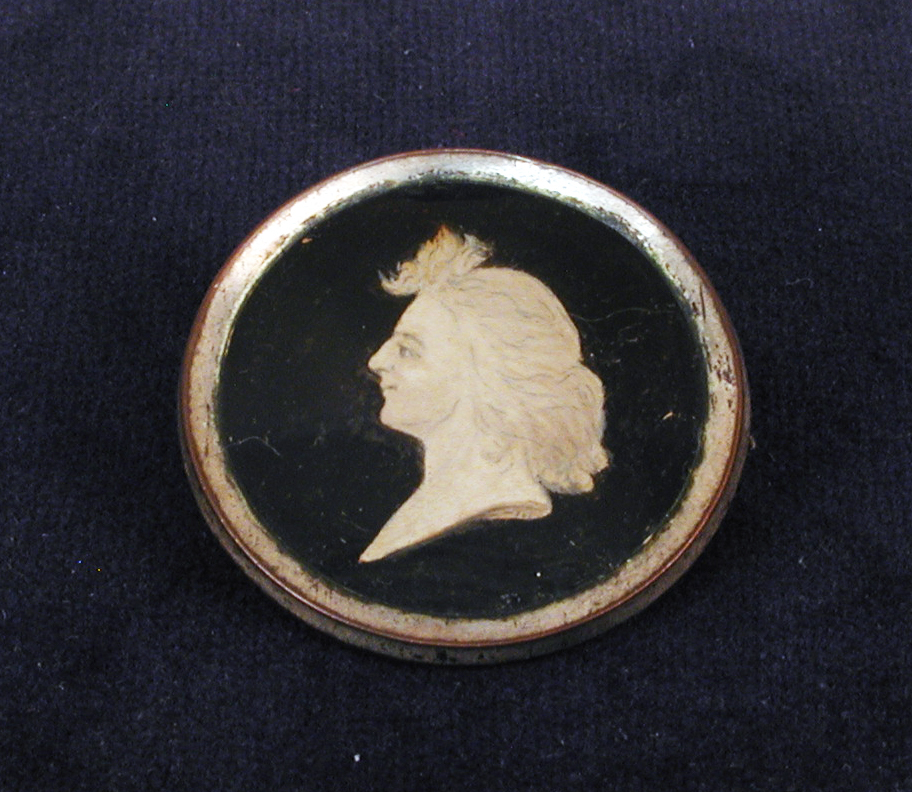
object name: button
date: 1801-1900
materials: glass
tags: profiles,women